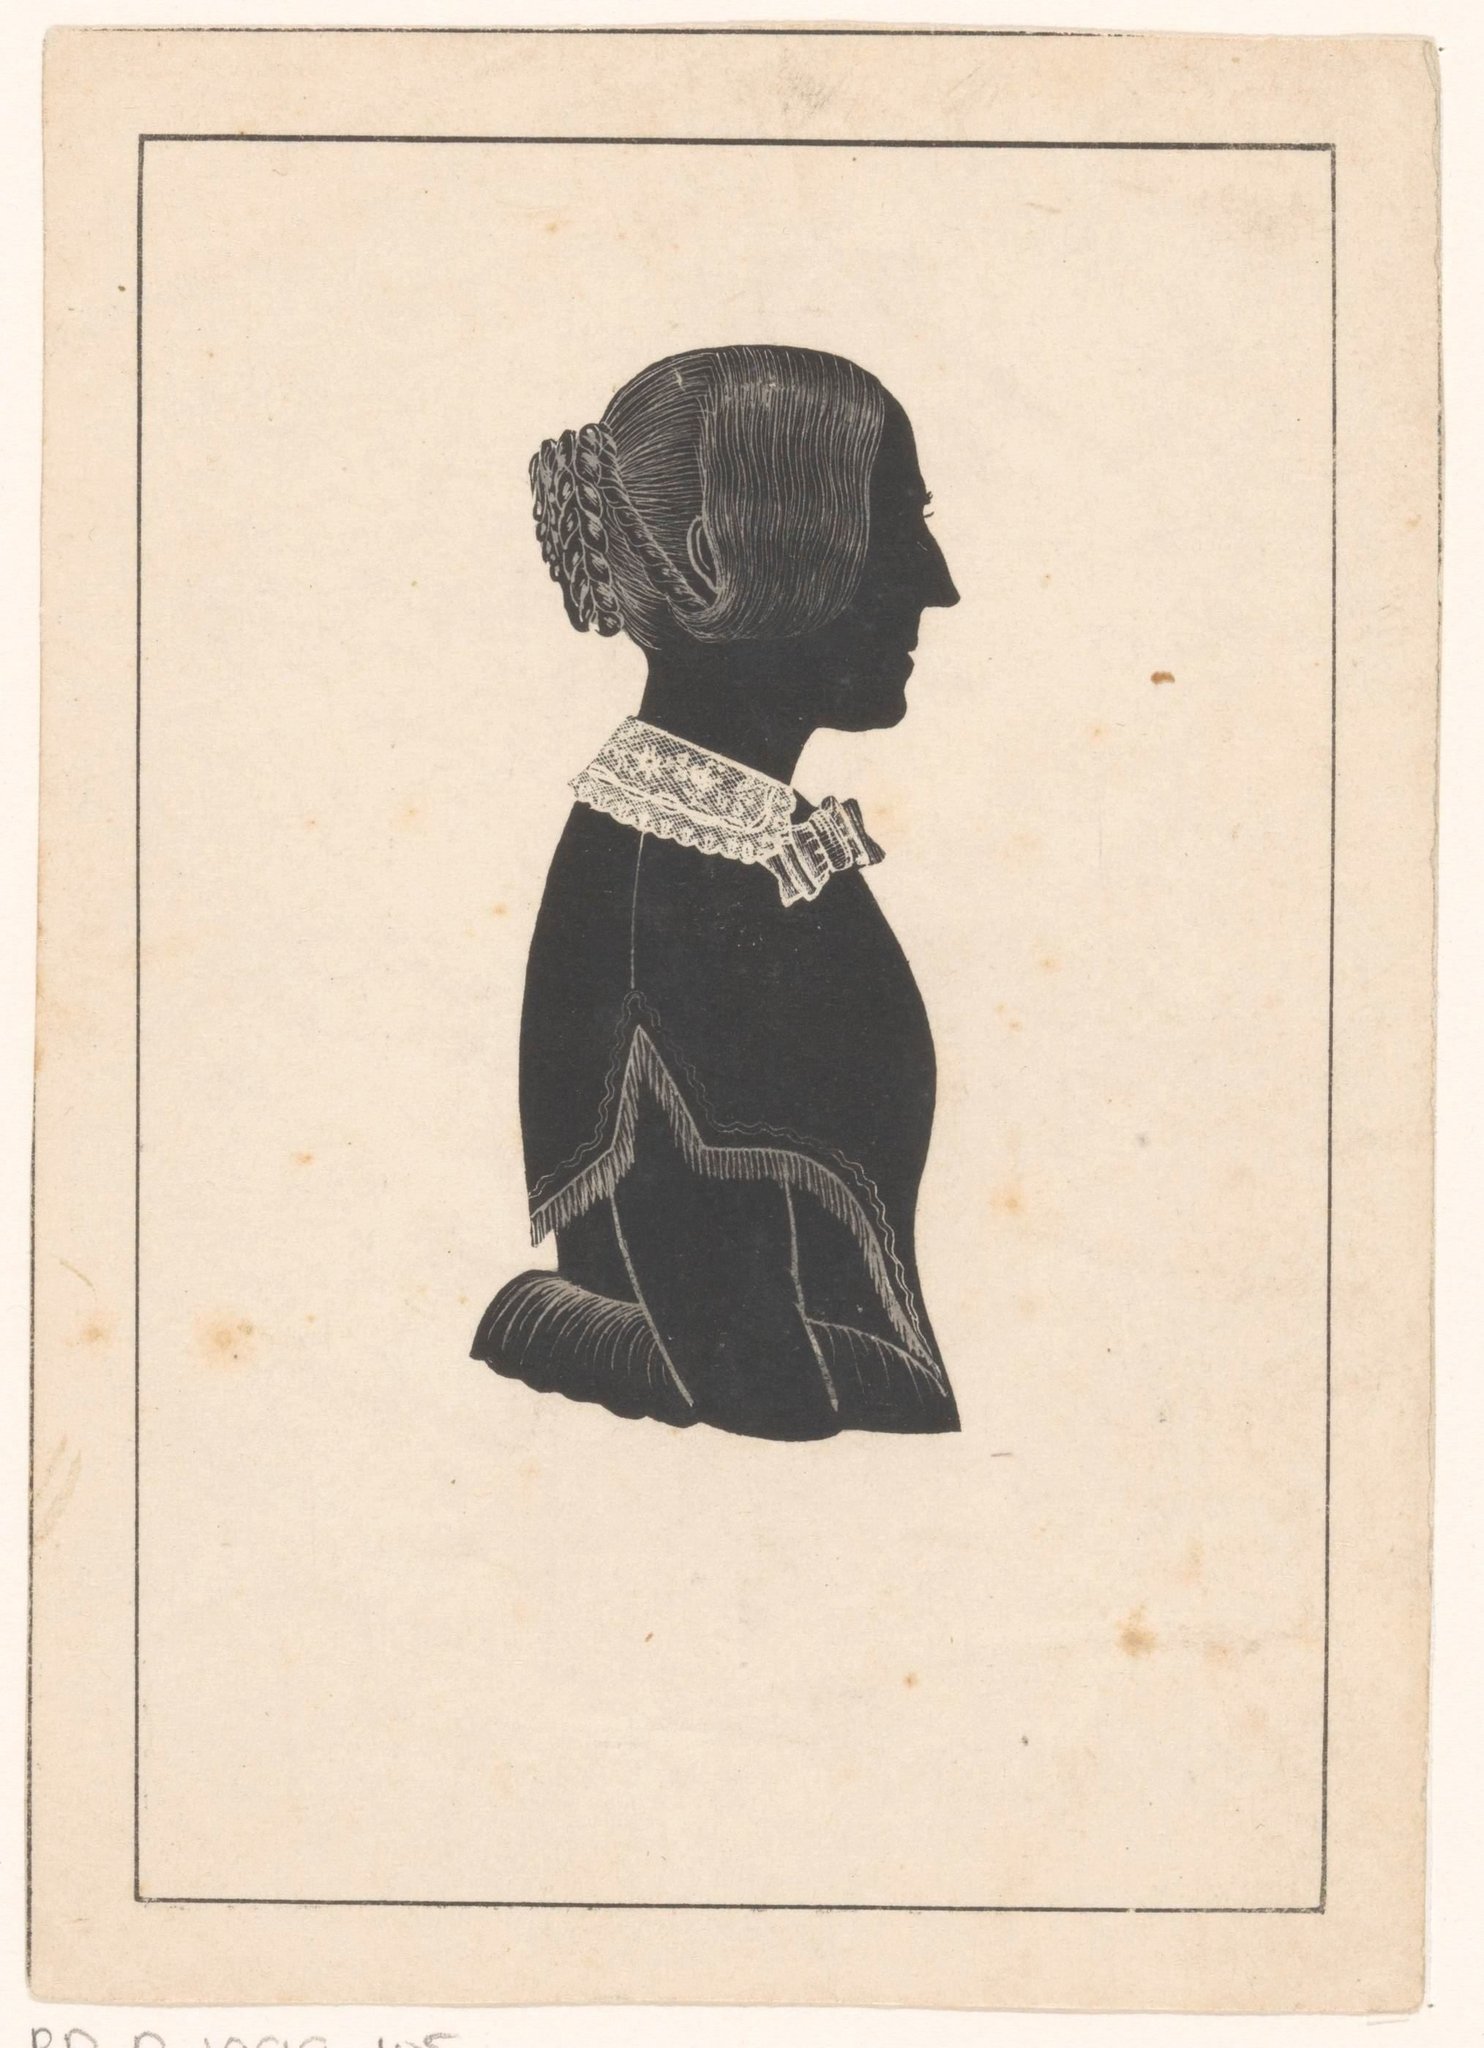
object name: print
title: Silhouetportret van Dingena Sophia van Galen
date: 1848-1862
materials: paper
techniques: hand coloring, lithograph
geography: netherlands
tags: historical persons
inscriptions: collector's mark: Lugt 2228